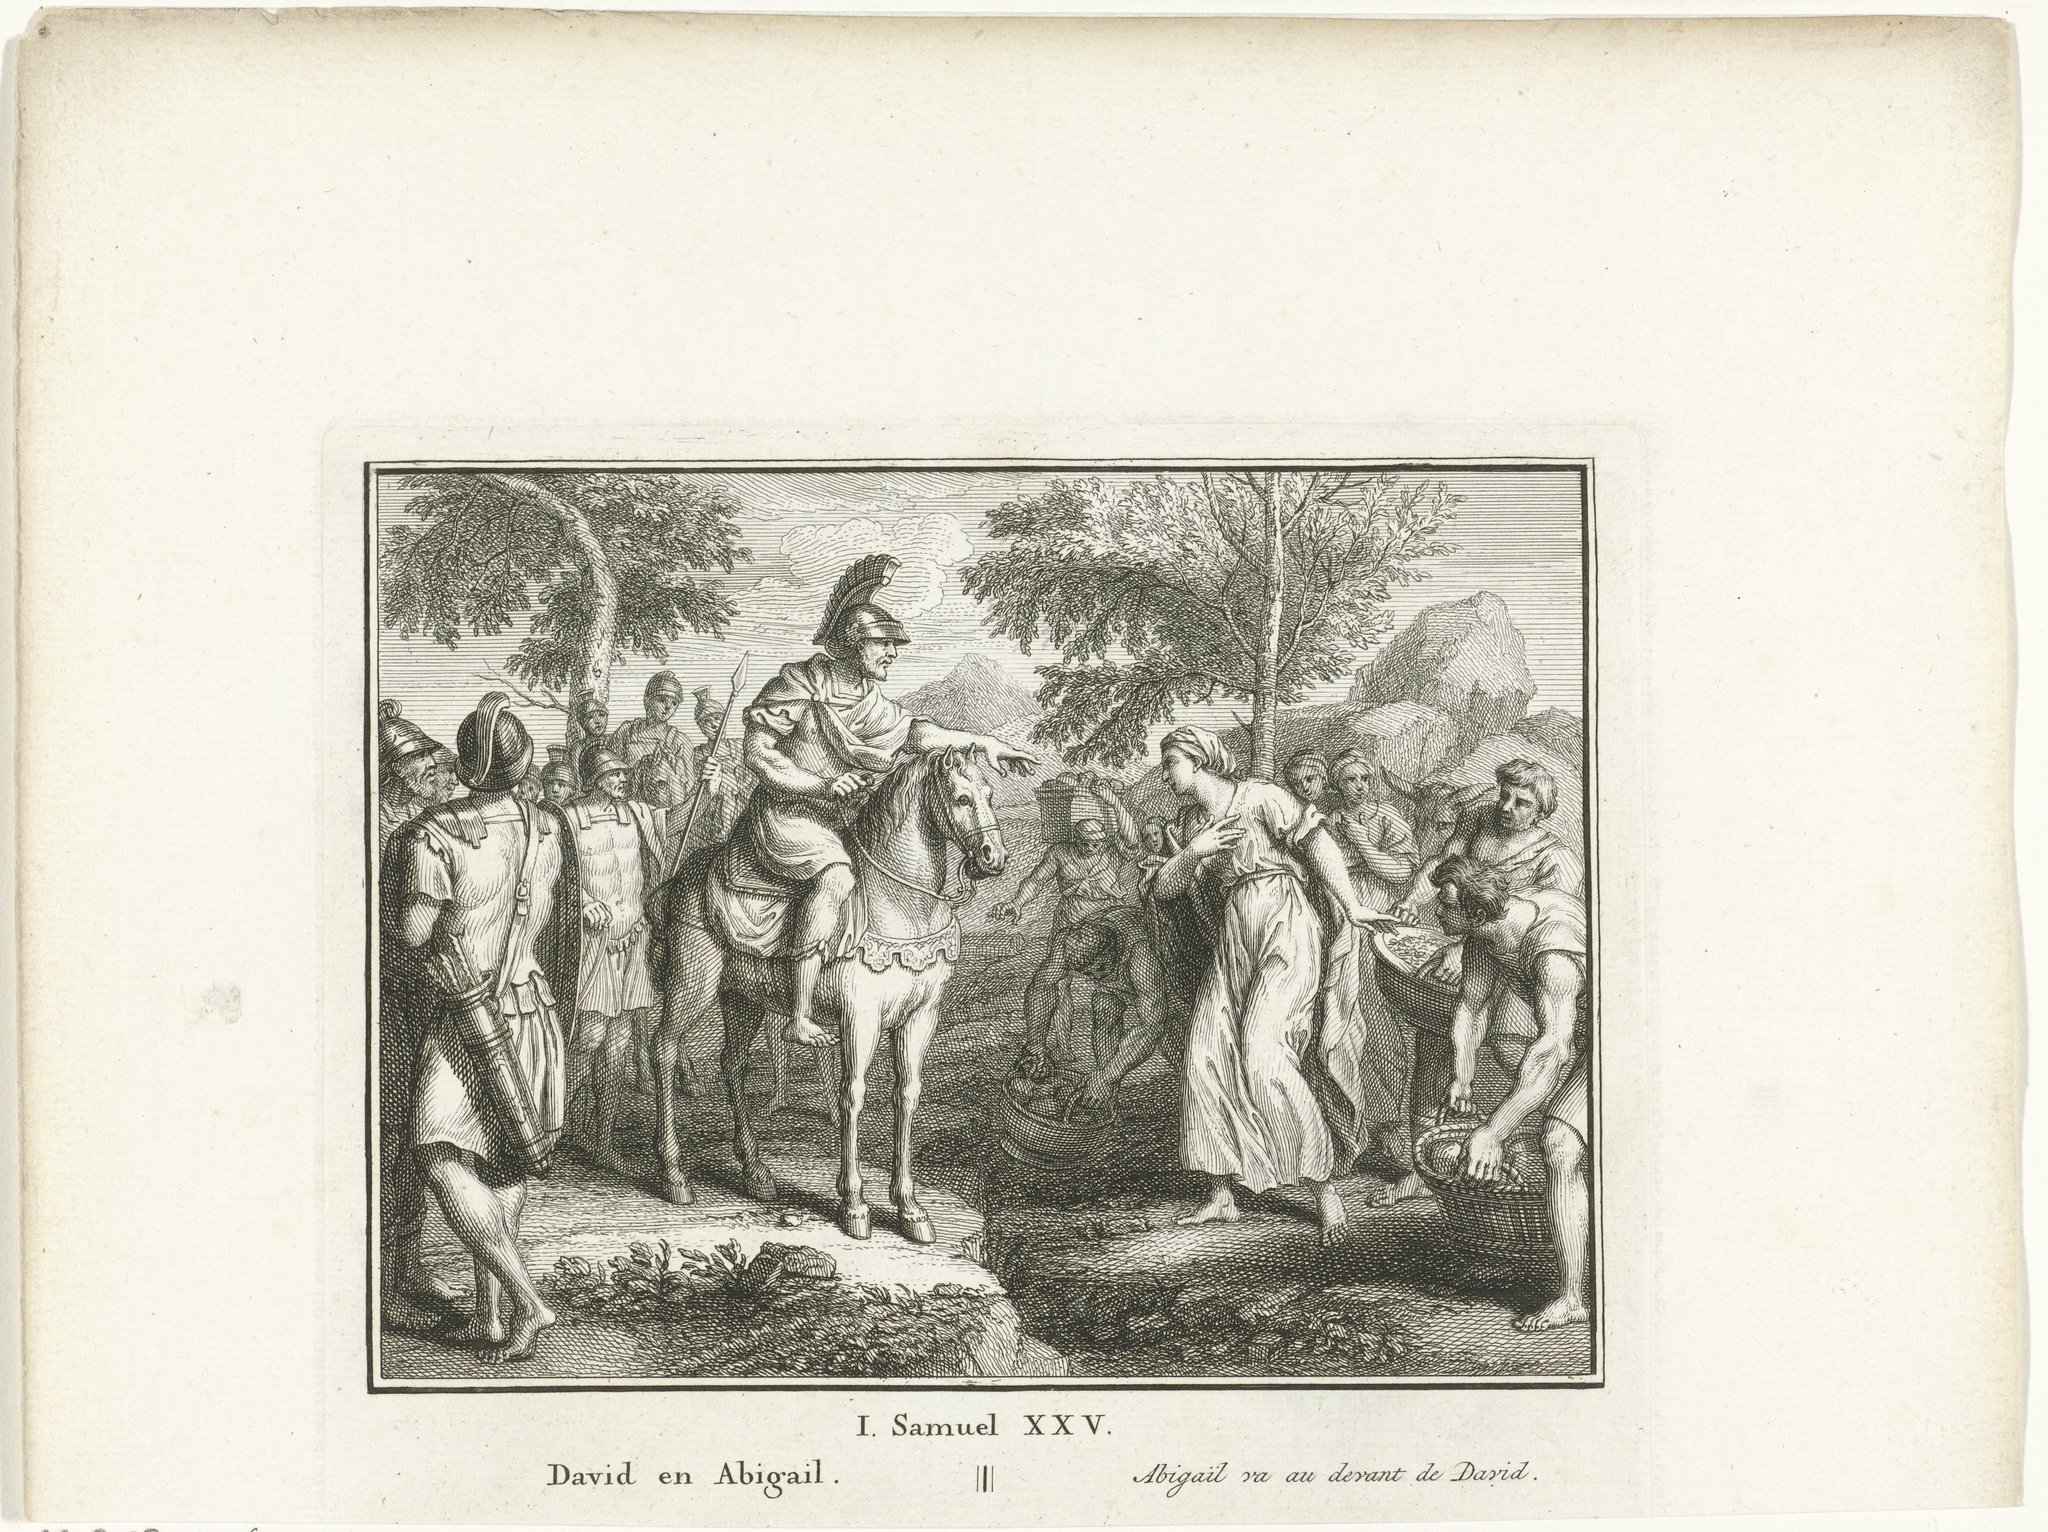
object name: print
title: Ontmoeting van David en Abigaïl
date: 1791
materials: paper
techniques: etching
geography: dordrecht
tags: david and abigail (1 samuel 25)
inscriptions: collector's mark: Lugt 2228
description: Illustratie uit: Hamelsveld, Ysbrand van. De gewigtigste geschiedenissen des Bybels, afgebeeld in twee honderd twee en vijftig printverbeeldingen (...) met eene zaaklijke uitbreiding opgehelderd. Amsterdam / Dordrecht: Jan de Groot / Abraham en Pieter Blussé.